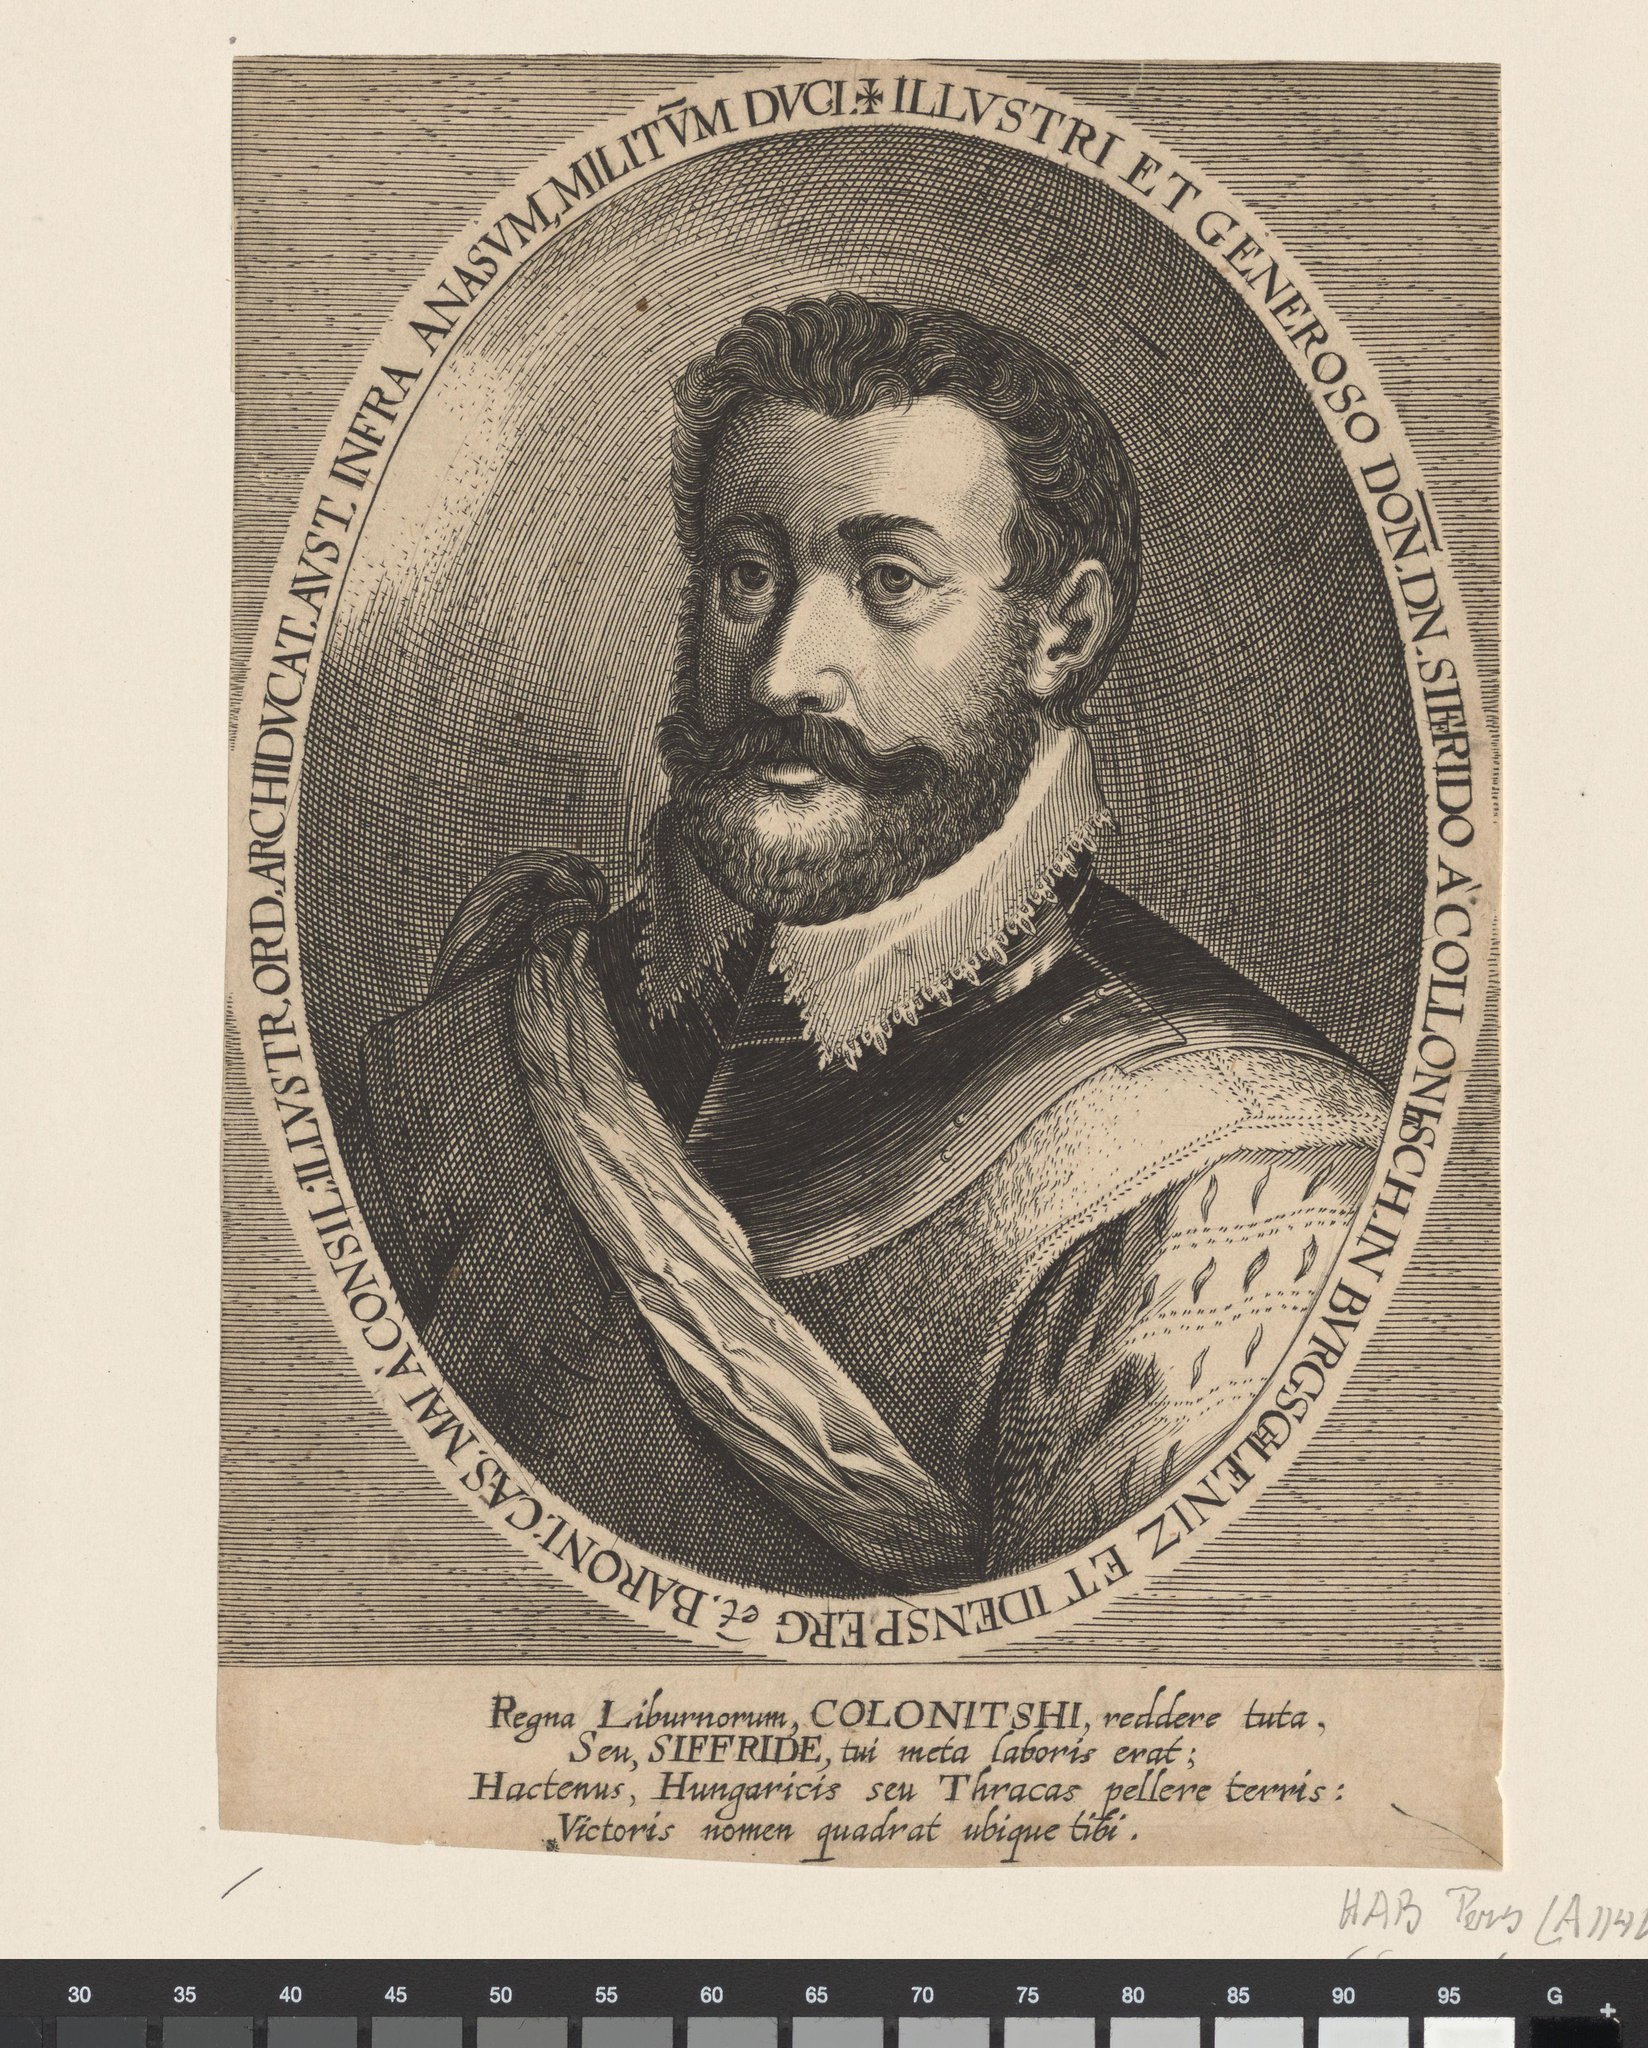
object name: print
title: Portret van Siegfried, baron van Kollonitsch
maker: dominicus custos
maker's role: print maker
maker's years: 1560-1615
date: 1597-1618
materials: paper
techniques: engraving, etching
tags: commander-in-chief, general, marshal, historical persons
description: Met een vierregelig onderschrift in het Latijn.